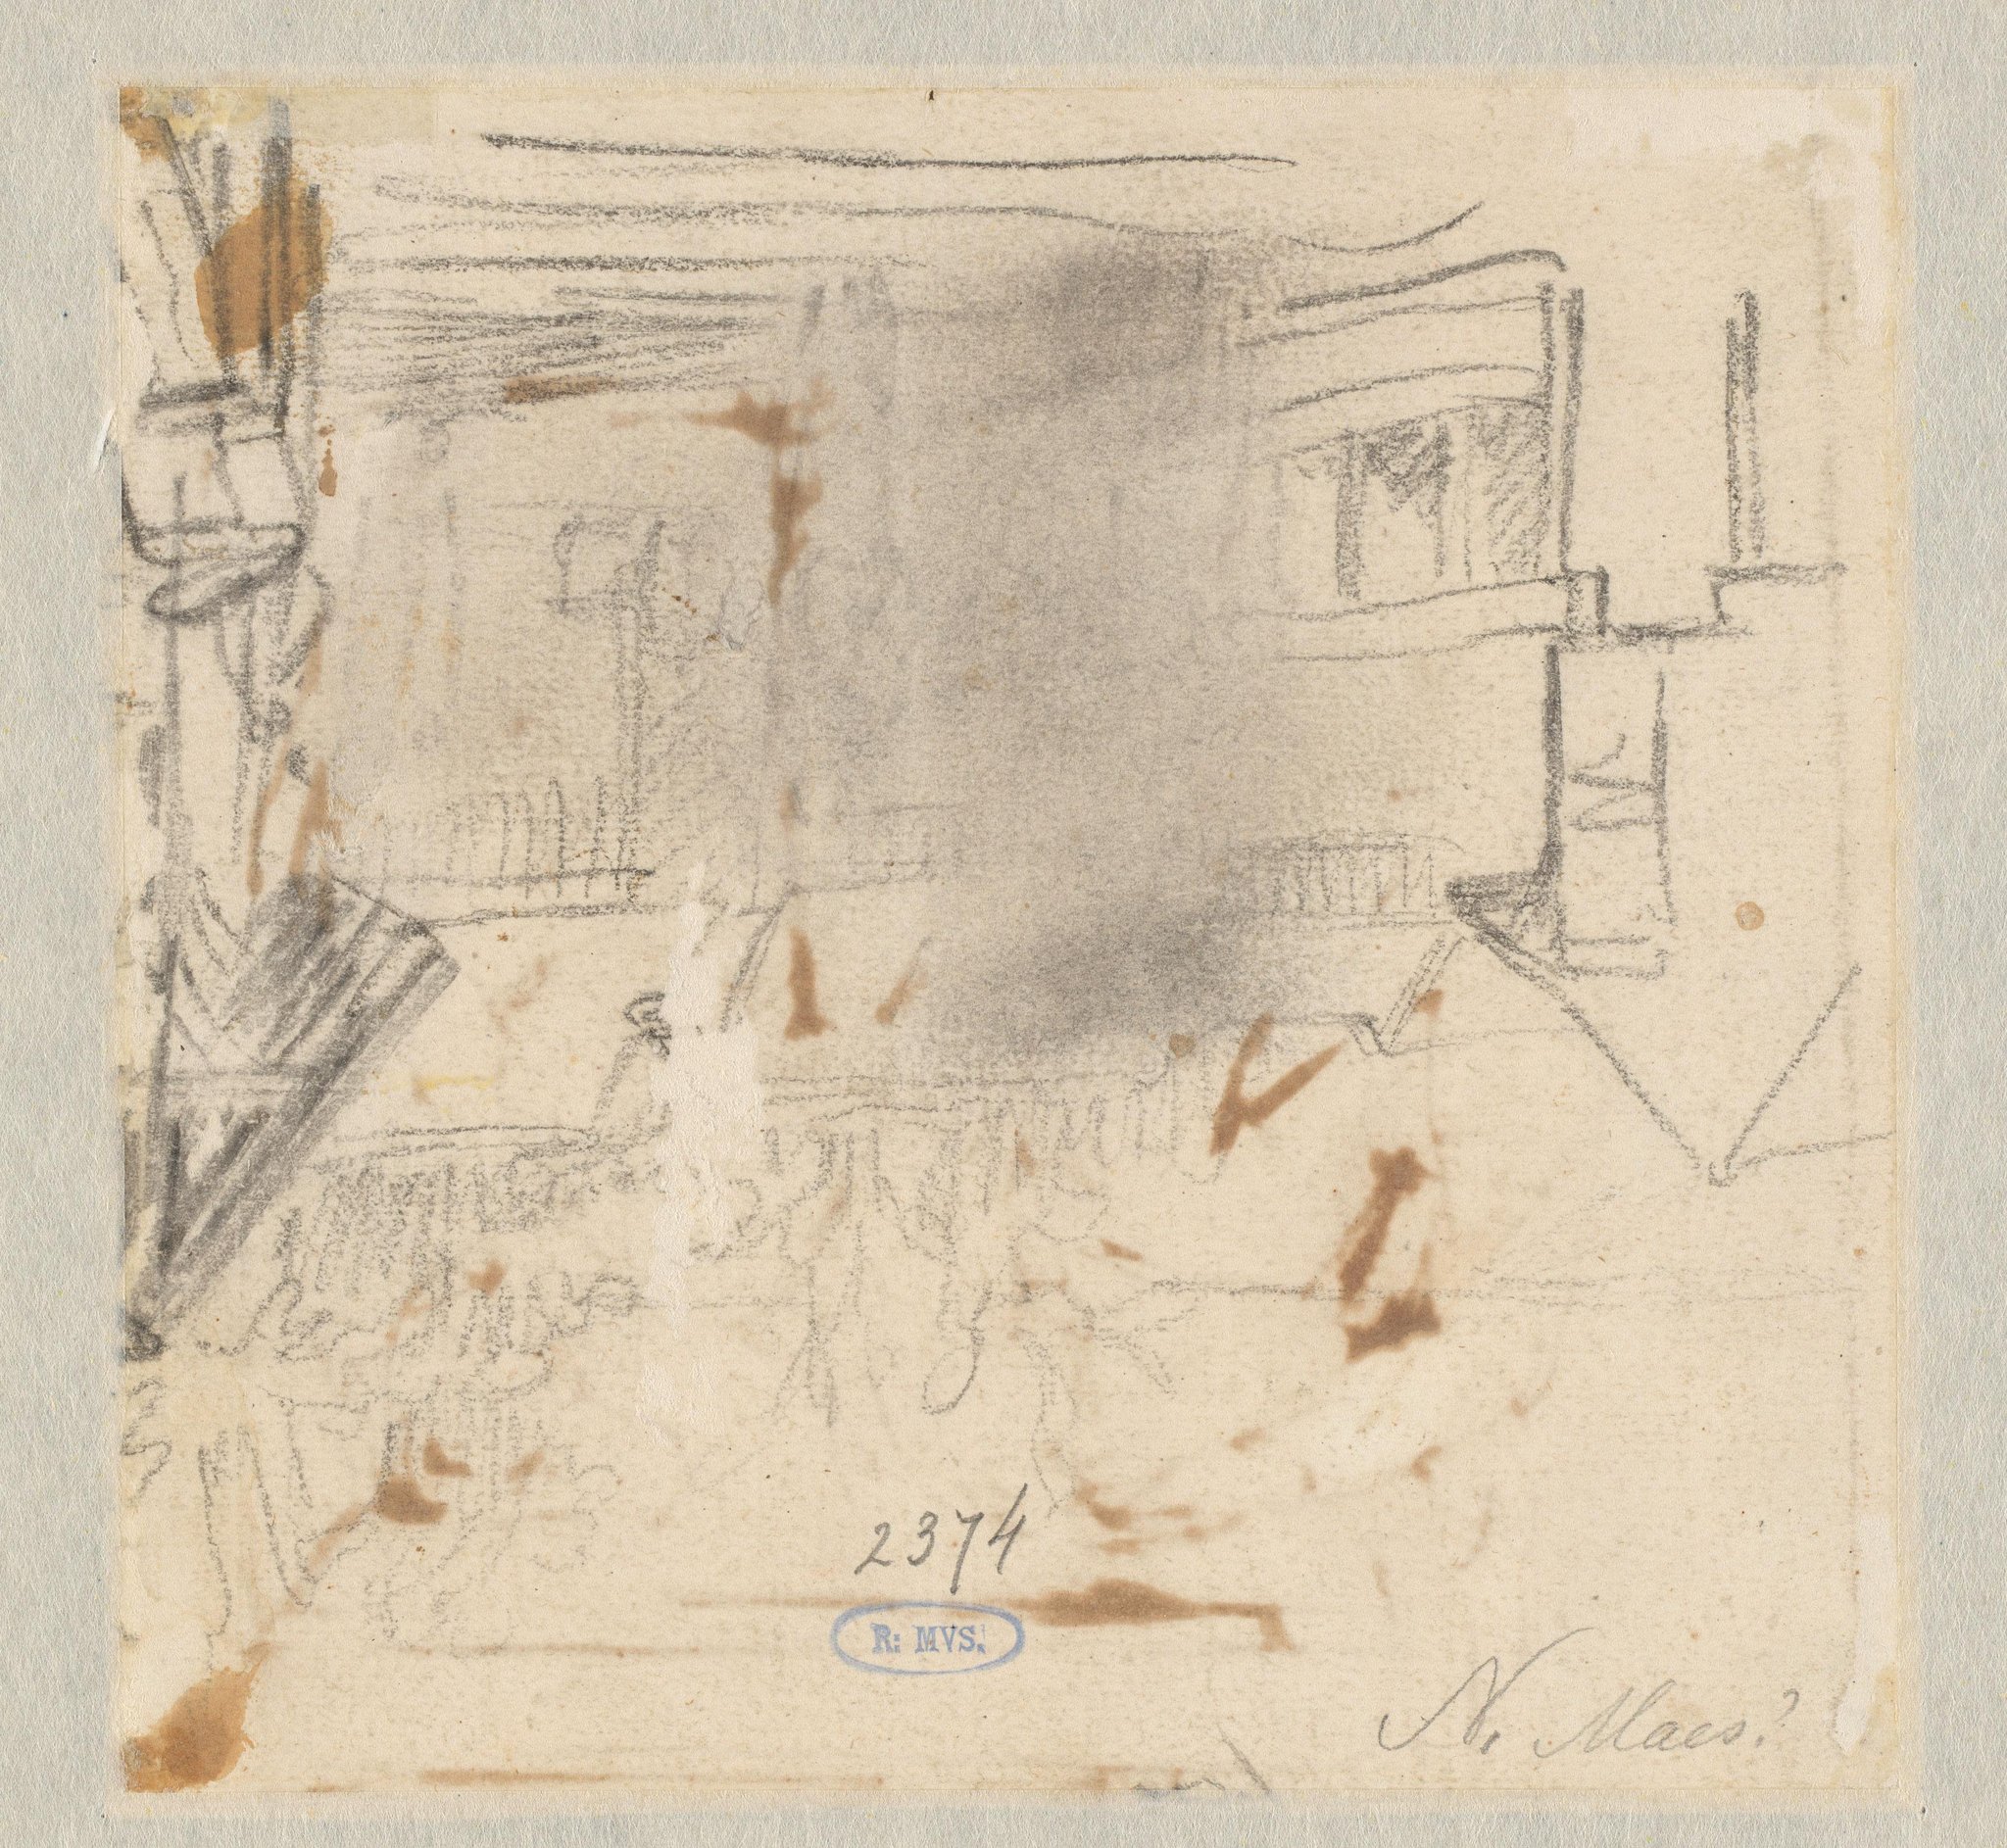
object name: drawing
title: Enkele huizen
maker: Anonymous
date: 1644-1750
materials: chalk, paper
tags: urban housing